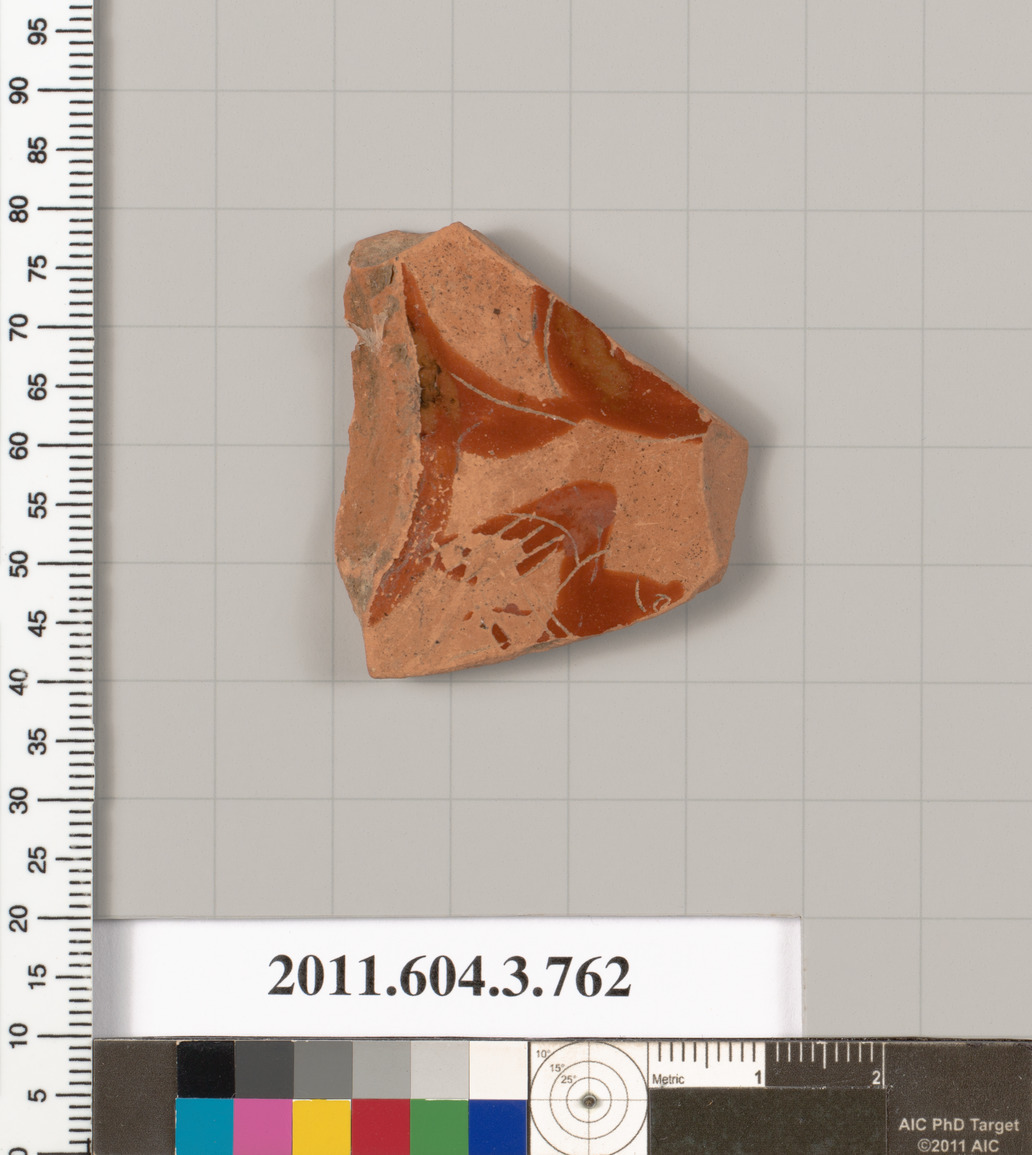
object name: neck amphora, tyrrhenian fragment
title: Terracotta fragment of a neck-amphora (jar)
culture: greek, attic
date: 575-551 BCE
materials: terracotta